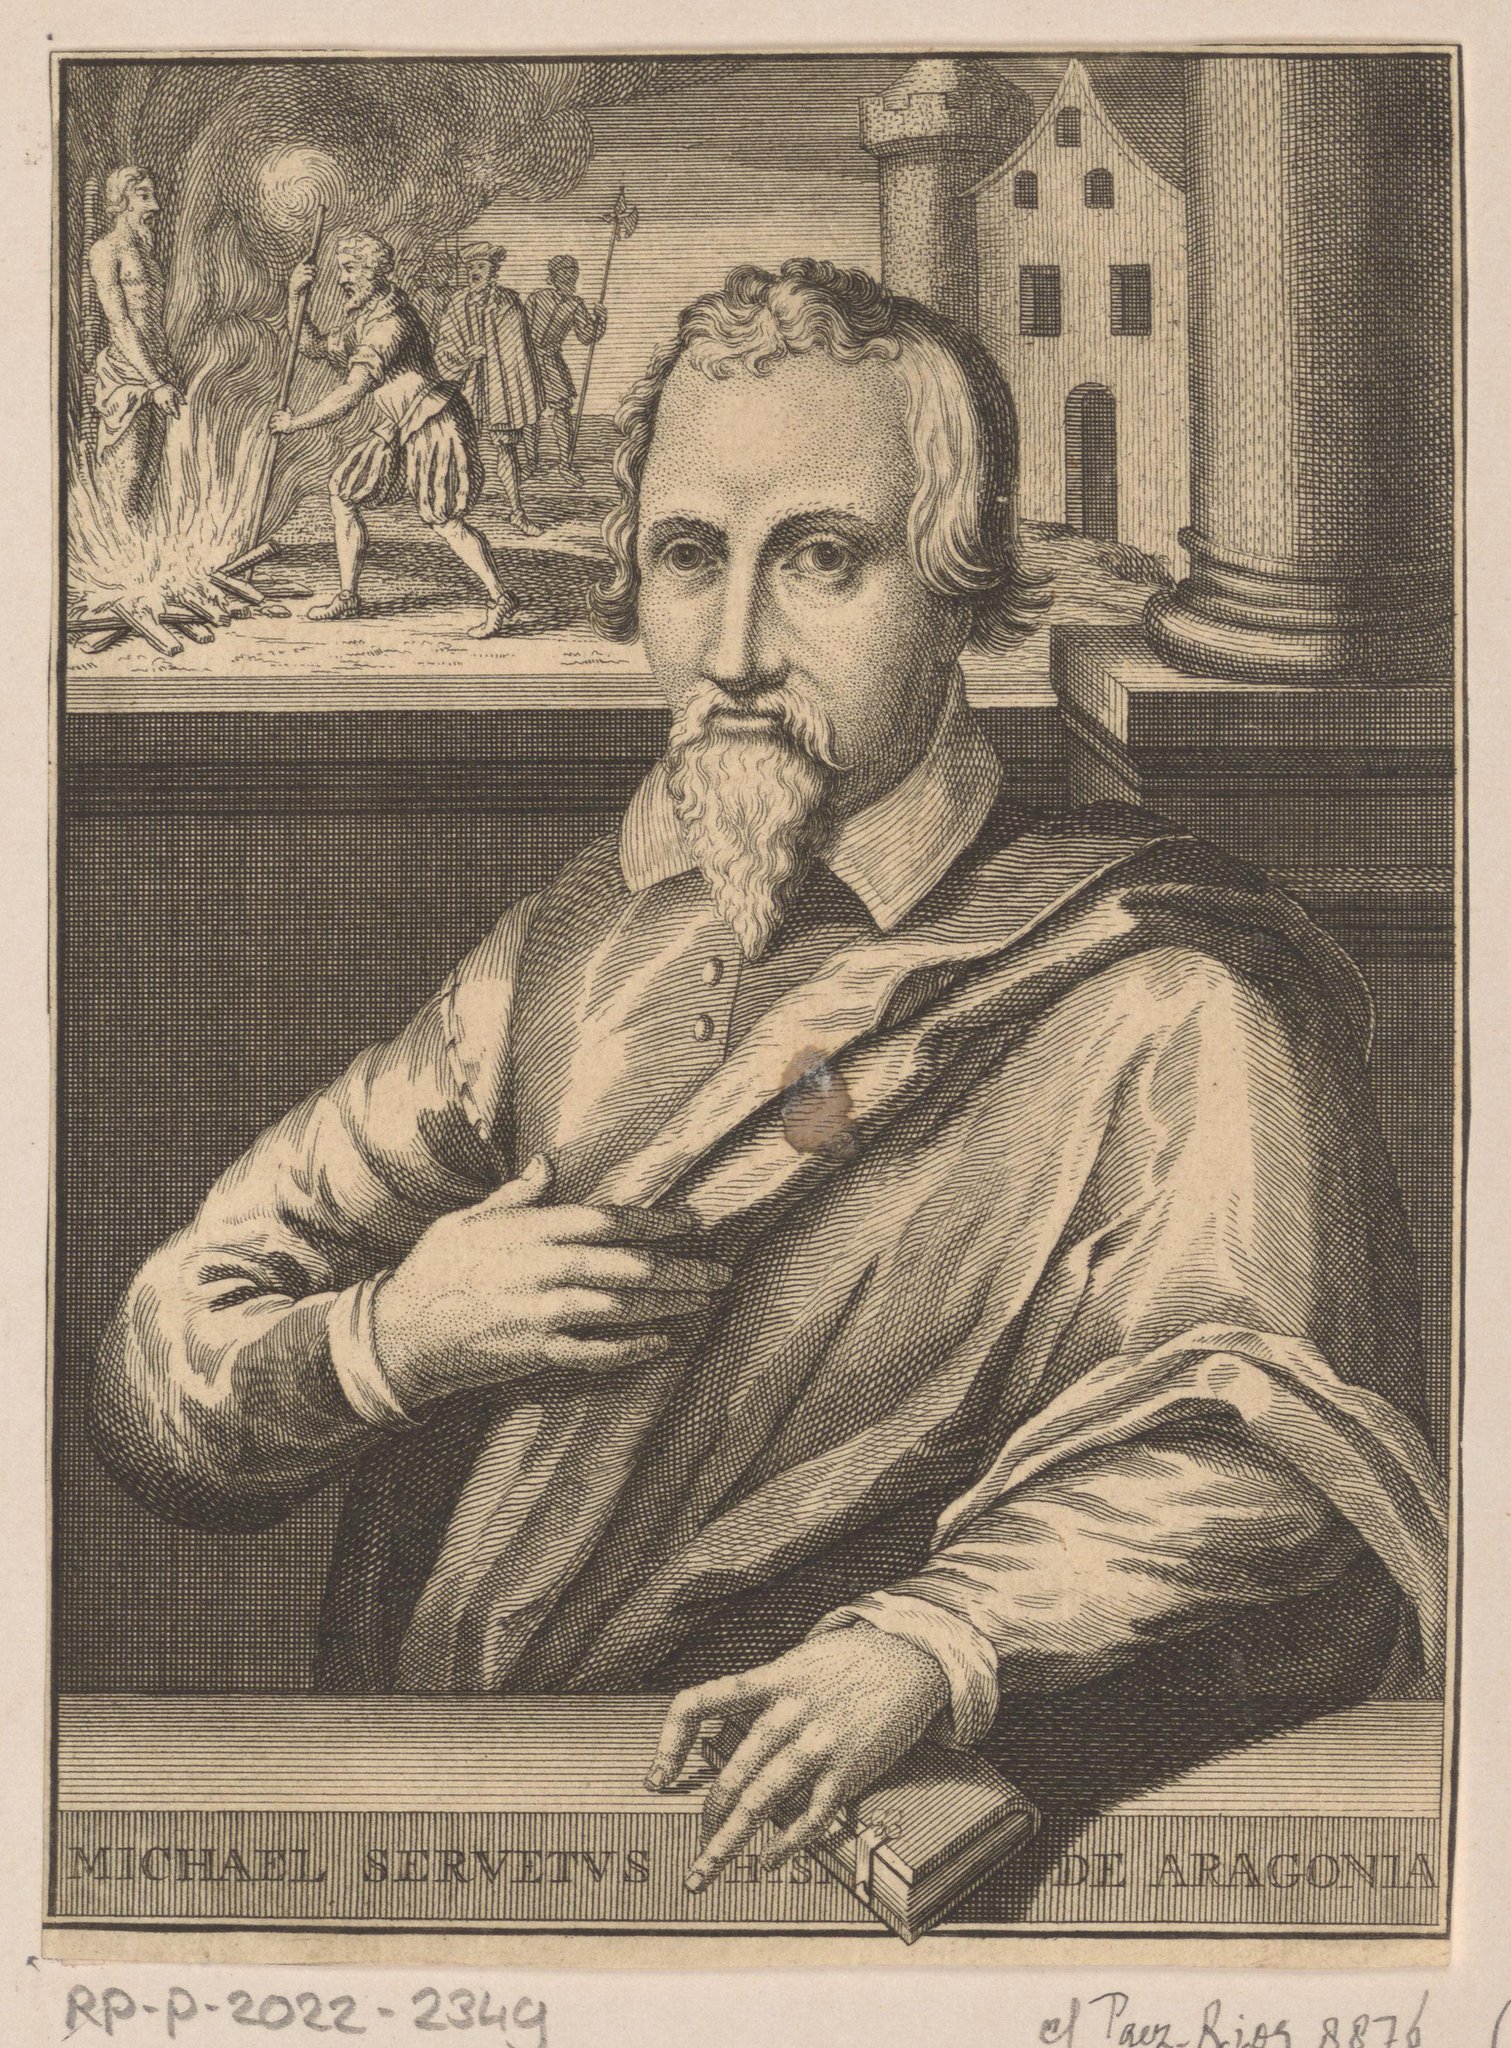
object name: print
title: Portret van Michael Servet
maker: Anonymous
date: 1729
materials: paper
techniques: engraving, etching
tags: theologian, historical persons, physician, doctor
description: Prent waarschijnlijk uit: Alwoerden, Henrik van. Historie van Michael Servetus den Spanjaart (...). Rotterdam: Jan Daniel Beman, 1729.